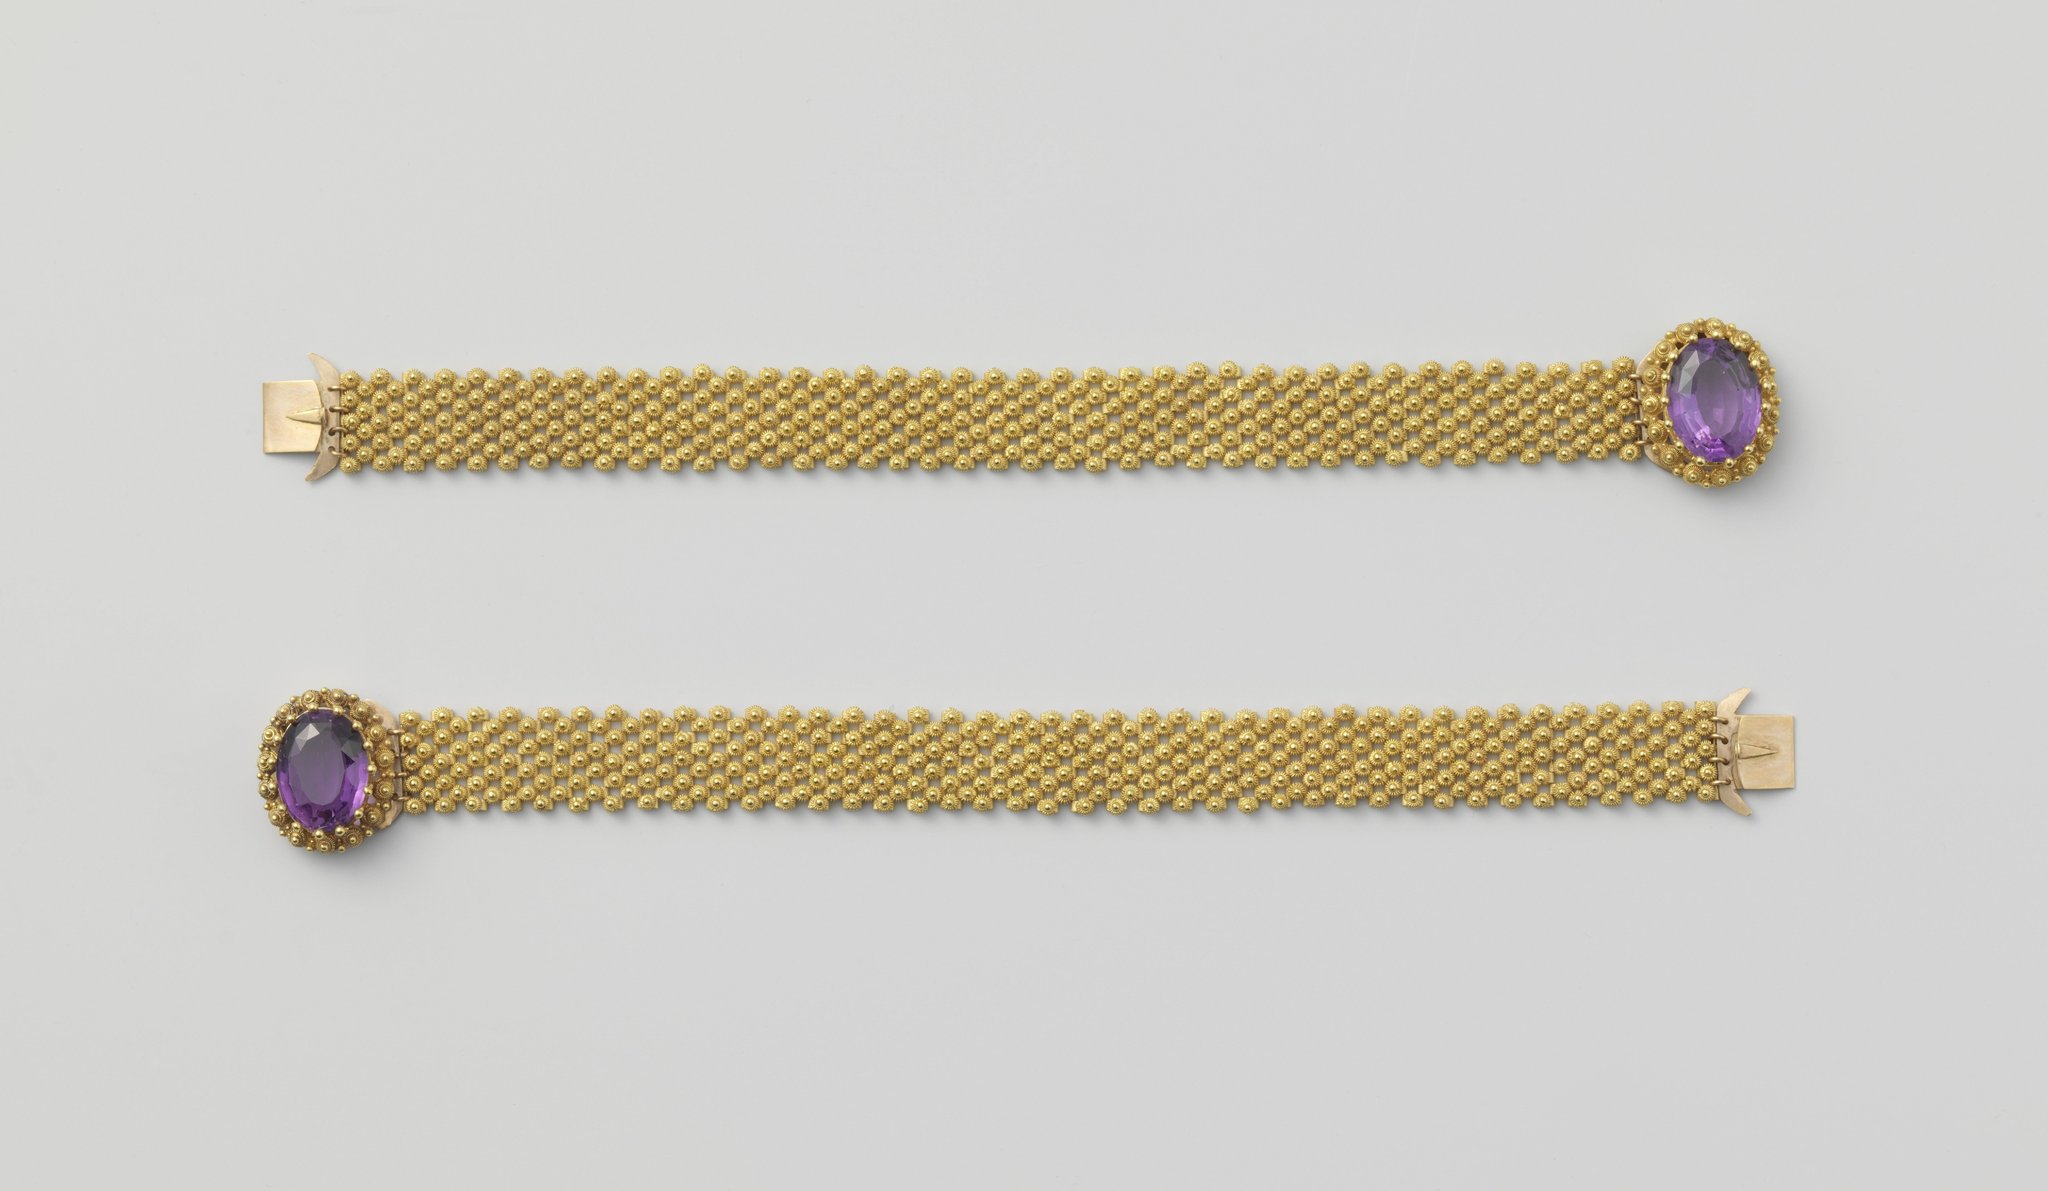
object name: jewellery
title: Armband van goud en amethist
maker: jean baptiste bonnard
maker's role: goldsmith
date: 1824-1829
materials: gemstone, gold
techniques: granulation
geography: amsterdam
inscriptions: alloy mark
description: Parure. Gold and amethyst. Amsterdam, c. 1824 - 1829, by Jean Baptiste Bonnard.